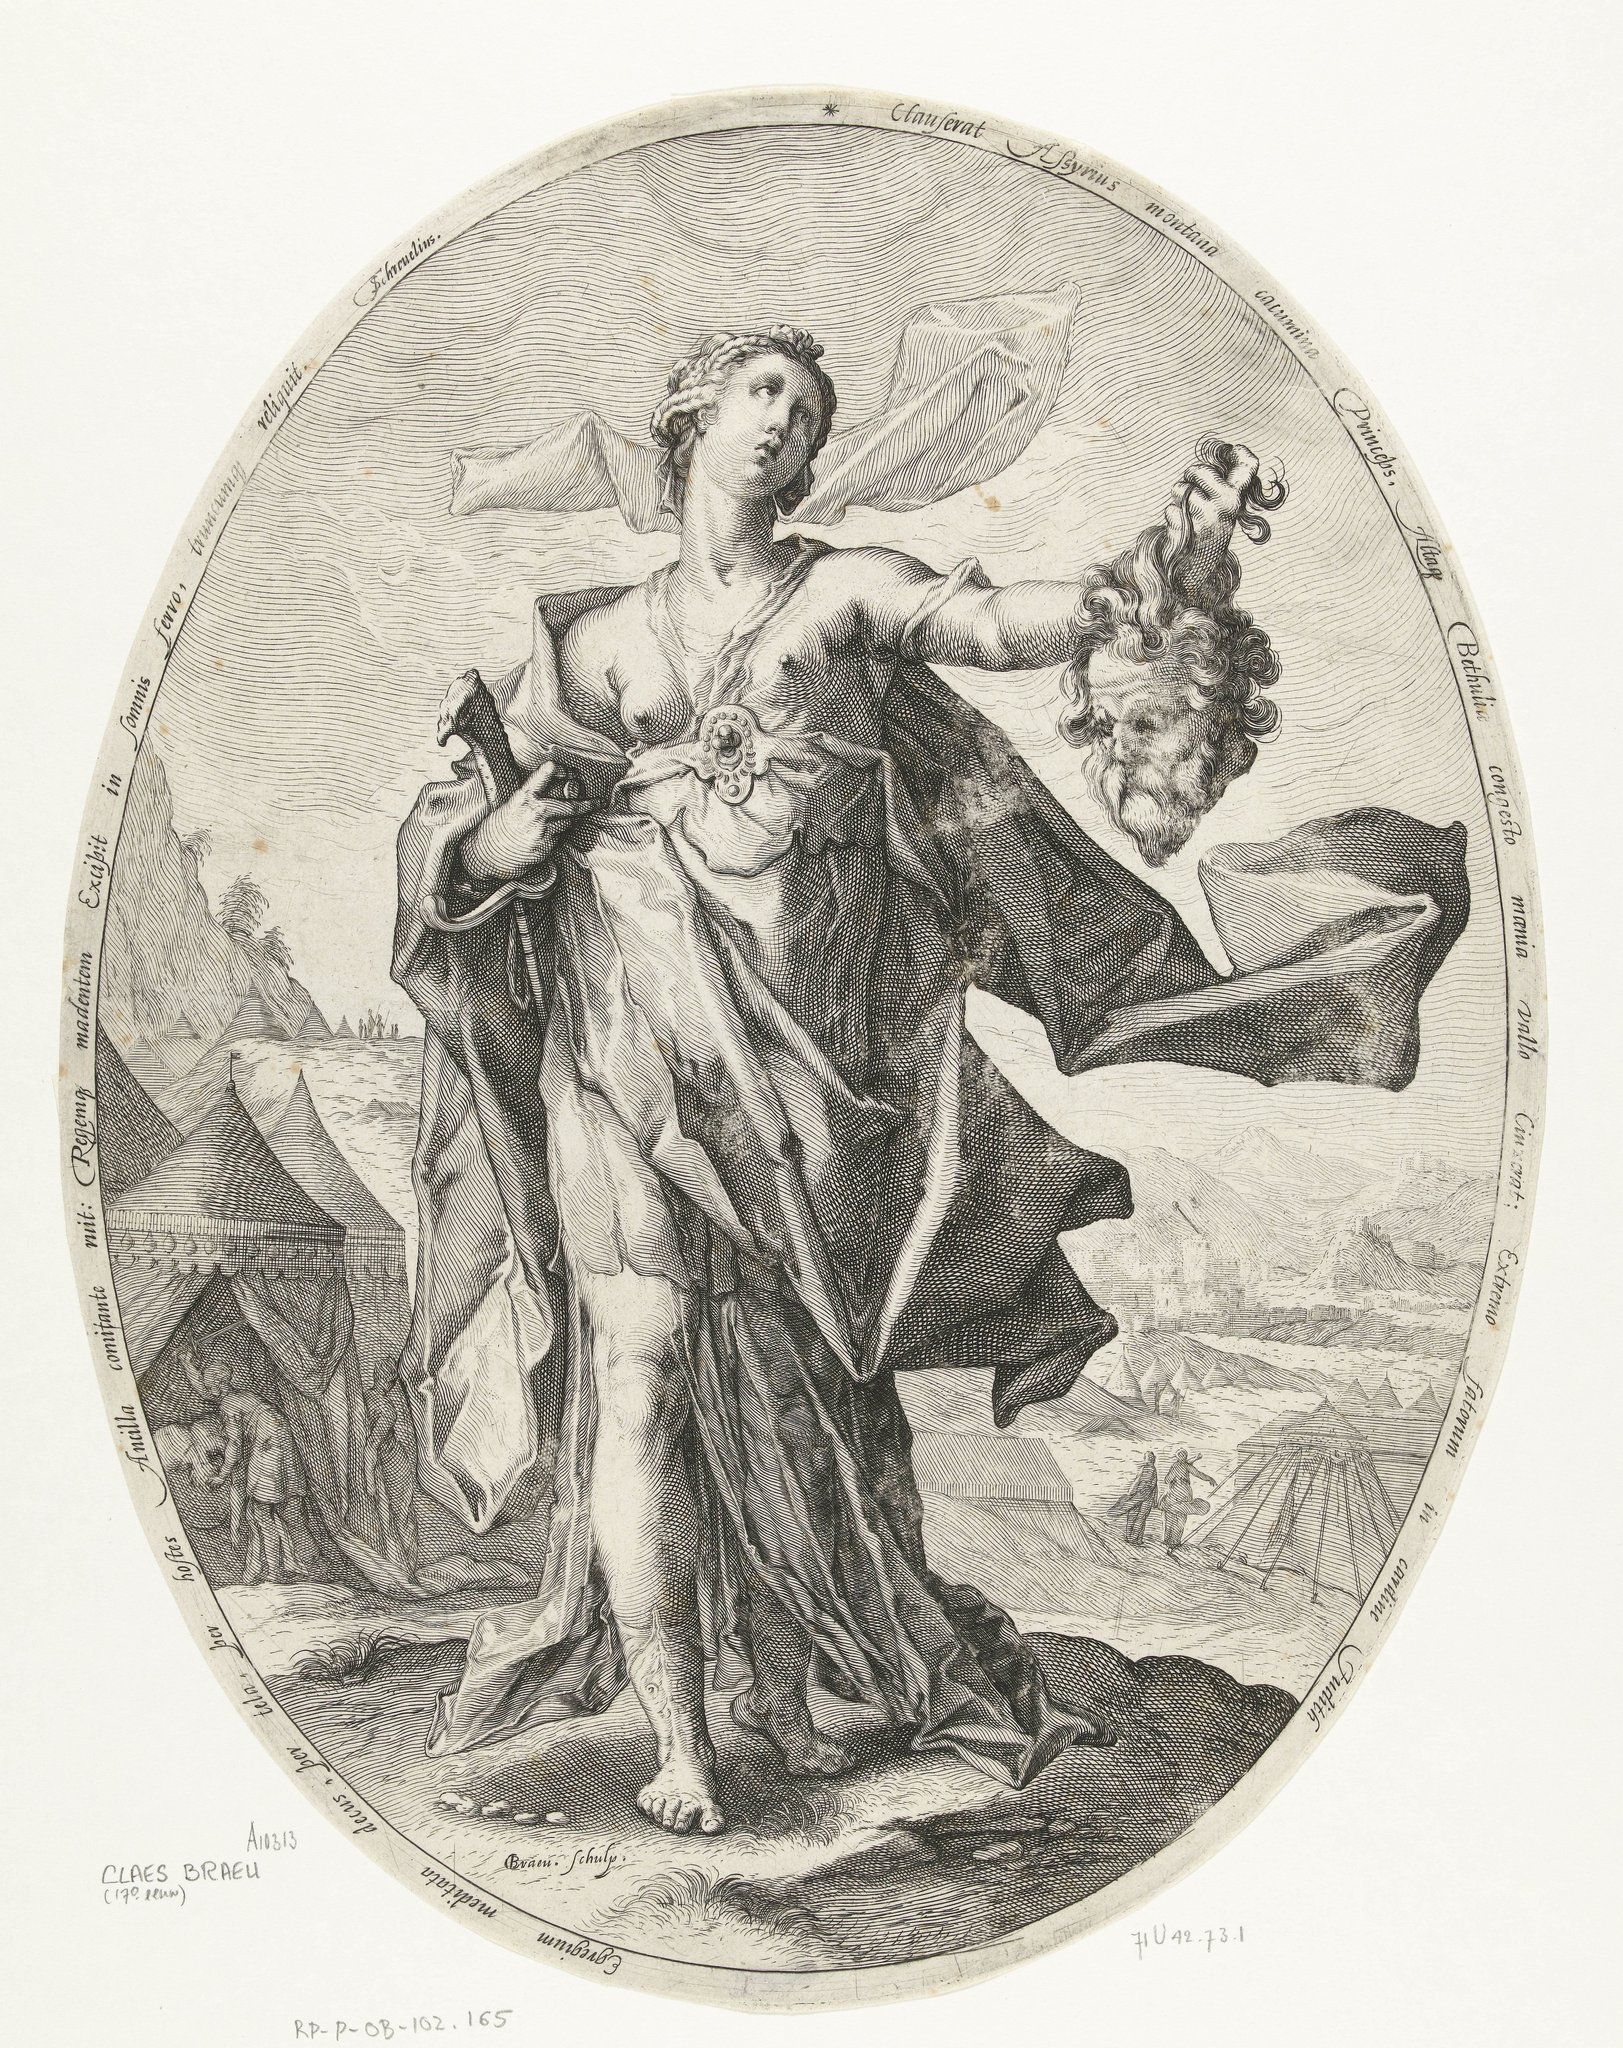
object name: print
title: Judit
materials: paper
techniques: engraving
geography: haarlem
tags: female persons from the old testament (with name) (not in biblical context)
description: Judit met het hoofd van Holofernes in haar hand. Het zwaard waarmee ze het hoofd afgehakt heeft is onder haar arm geklemd. Op de achtergrond is te zien hoe Judit het hoofd van de legeraanvoerder Holofernes afhakt in zijn tent. Haar dienstmaagd staat voor de tent en houdt de wacht. In ovaal met randschrift in het Latijn door Theodorus Schrevelius.